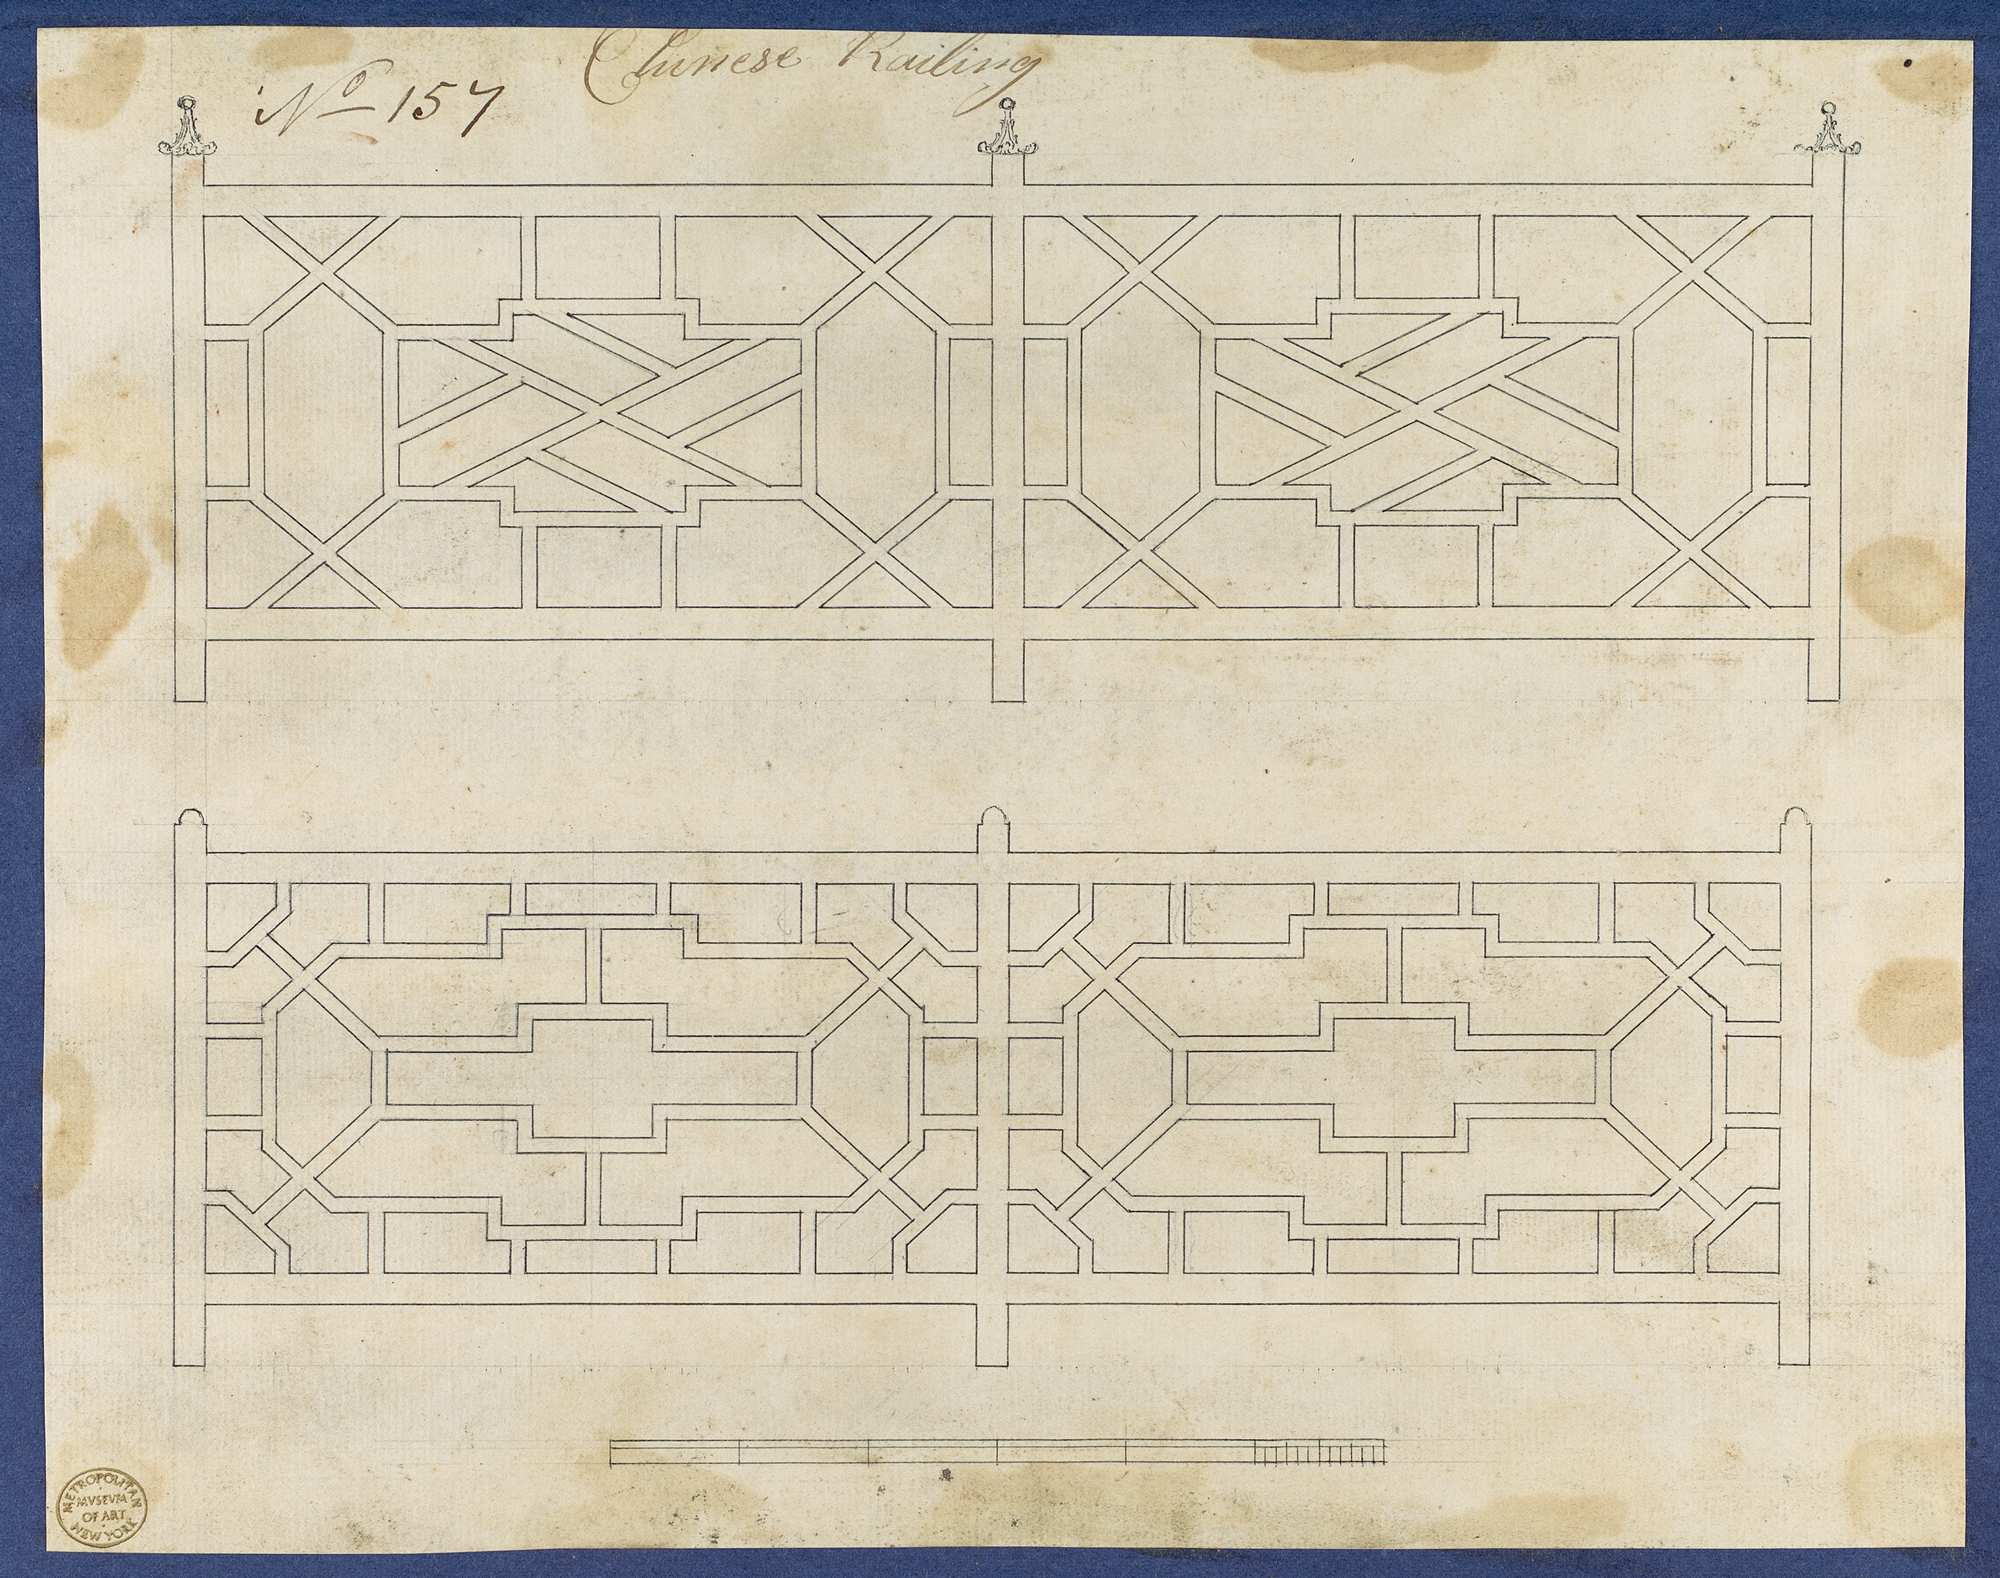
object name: drawing ornament architecture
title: Chinese Railing, from Chippendale Drawings, Vol. II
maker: thomas chippendale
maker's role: artist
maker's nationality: british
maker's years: 1718-1779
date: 1754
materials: ink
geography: london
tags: ornament